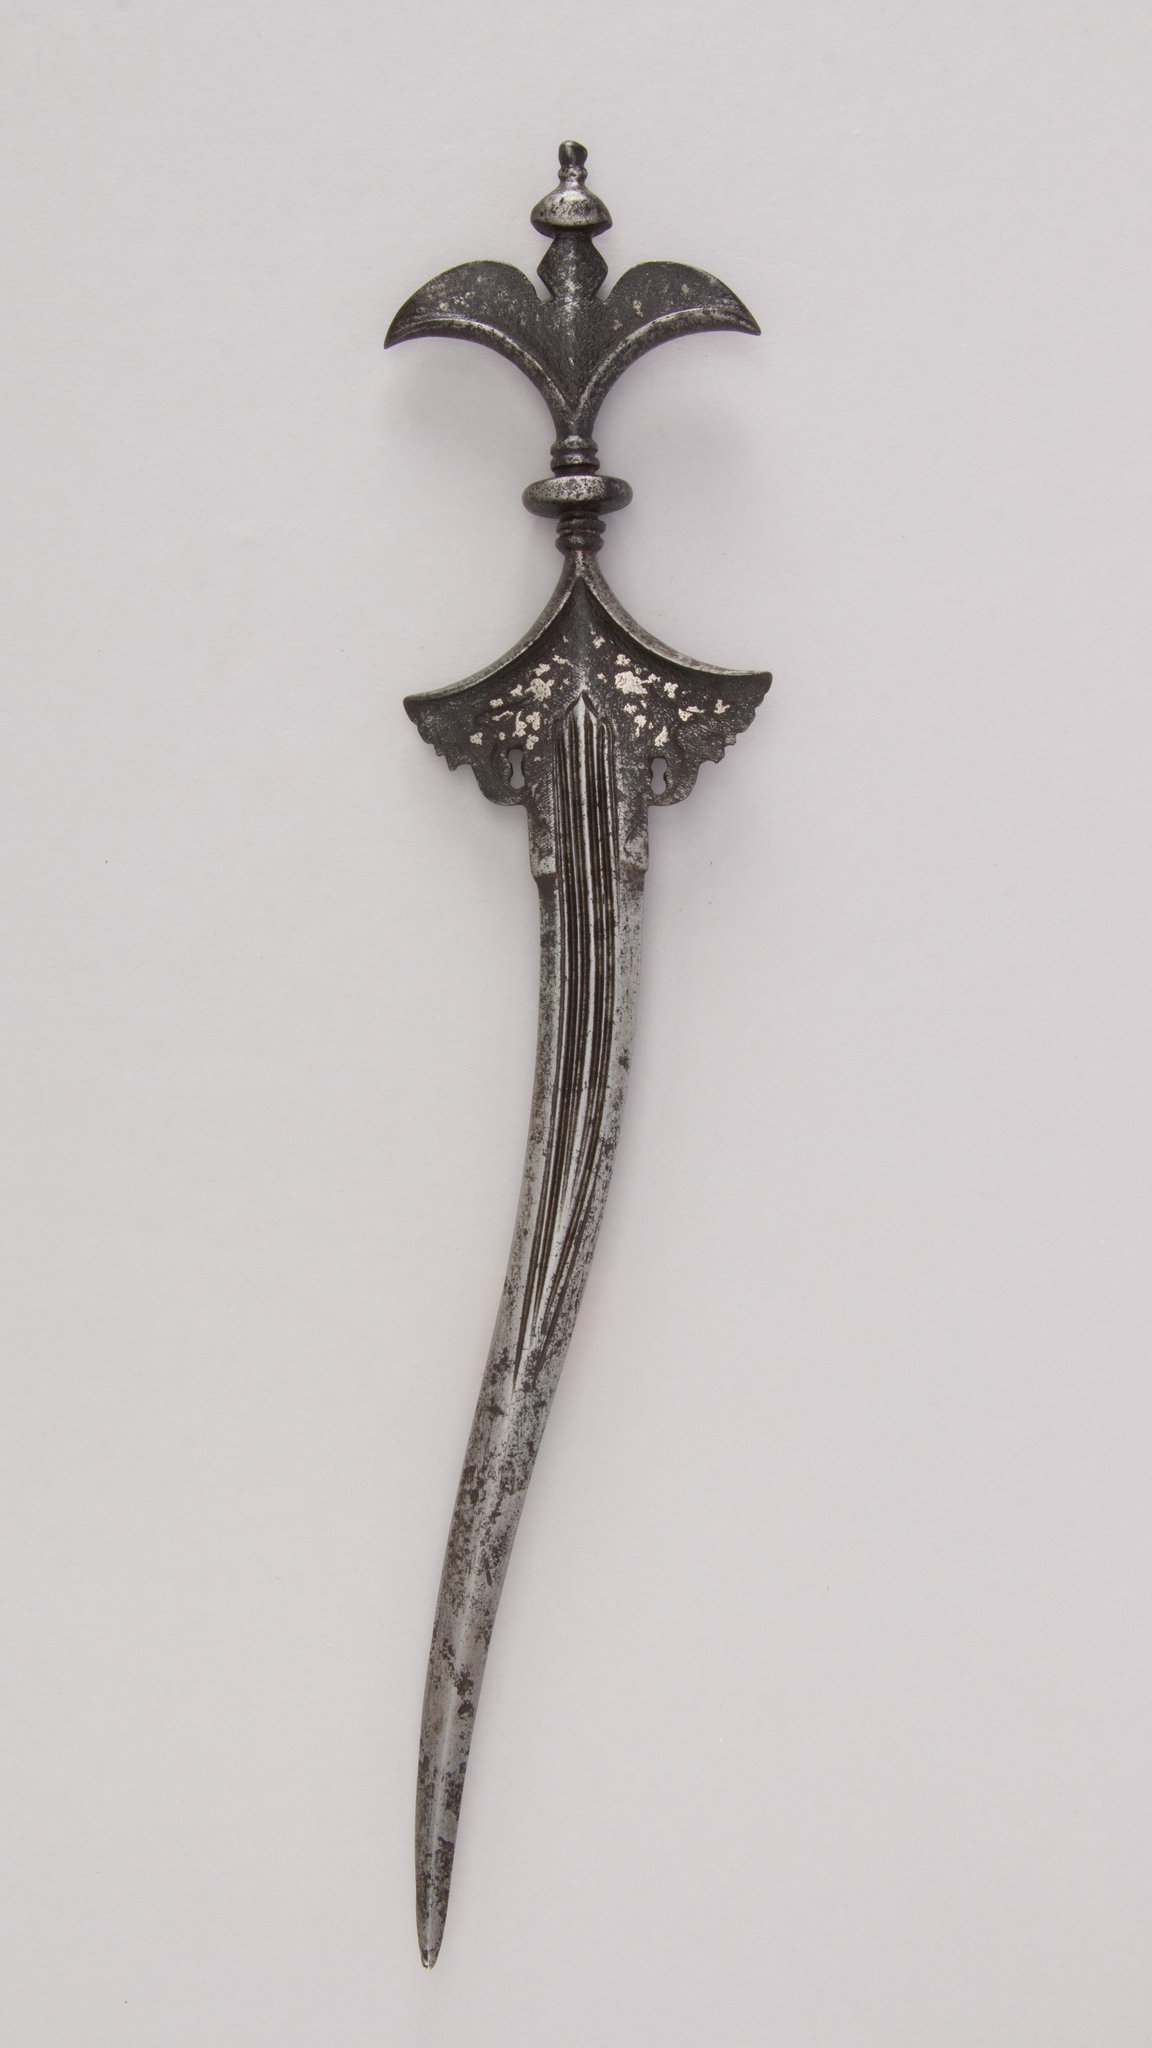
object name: dagger chilanum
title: Dagger (Chilanum)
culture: south indian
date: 1601-1700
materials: silver, steel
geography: south india